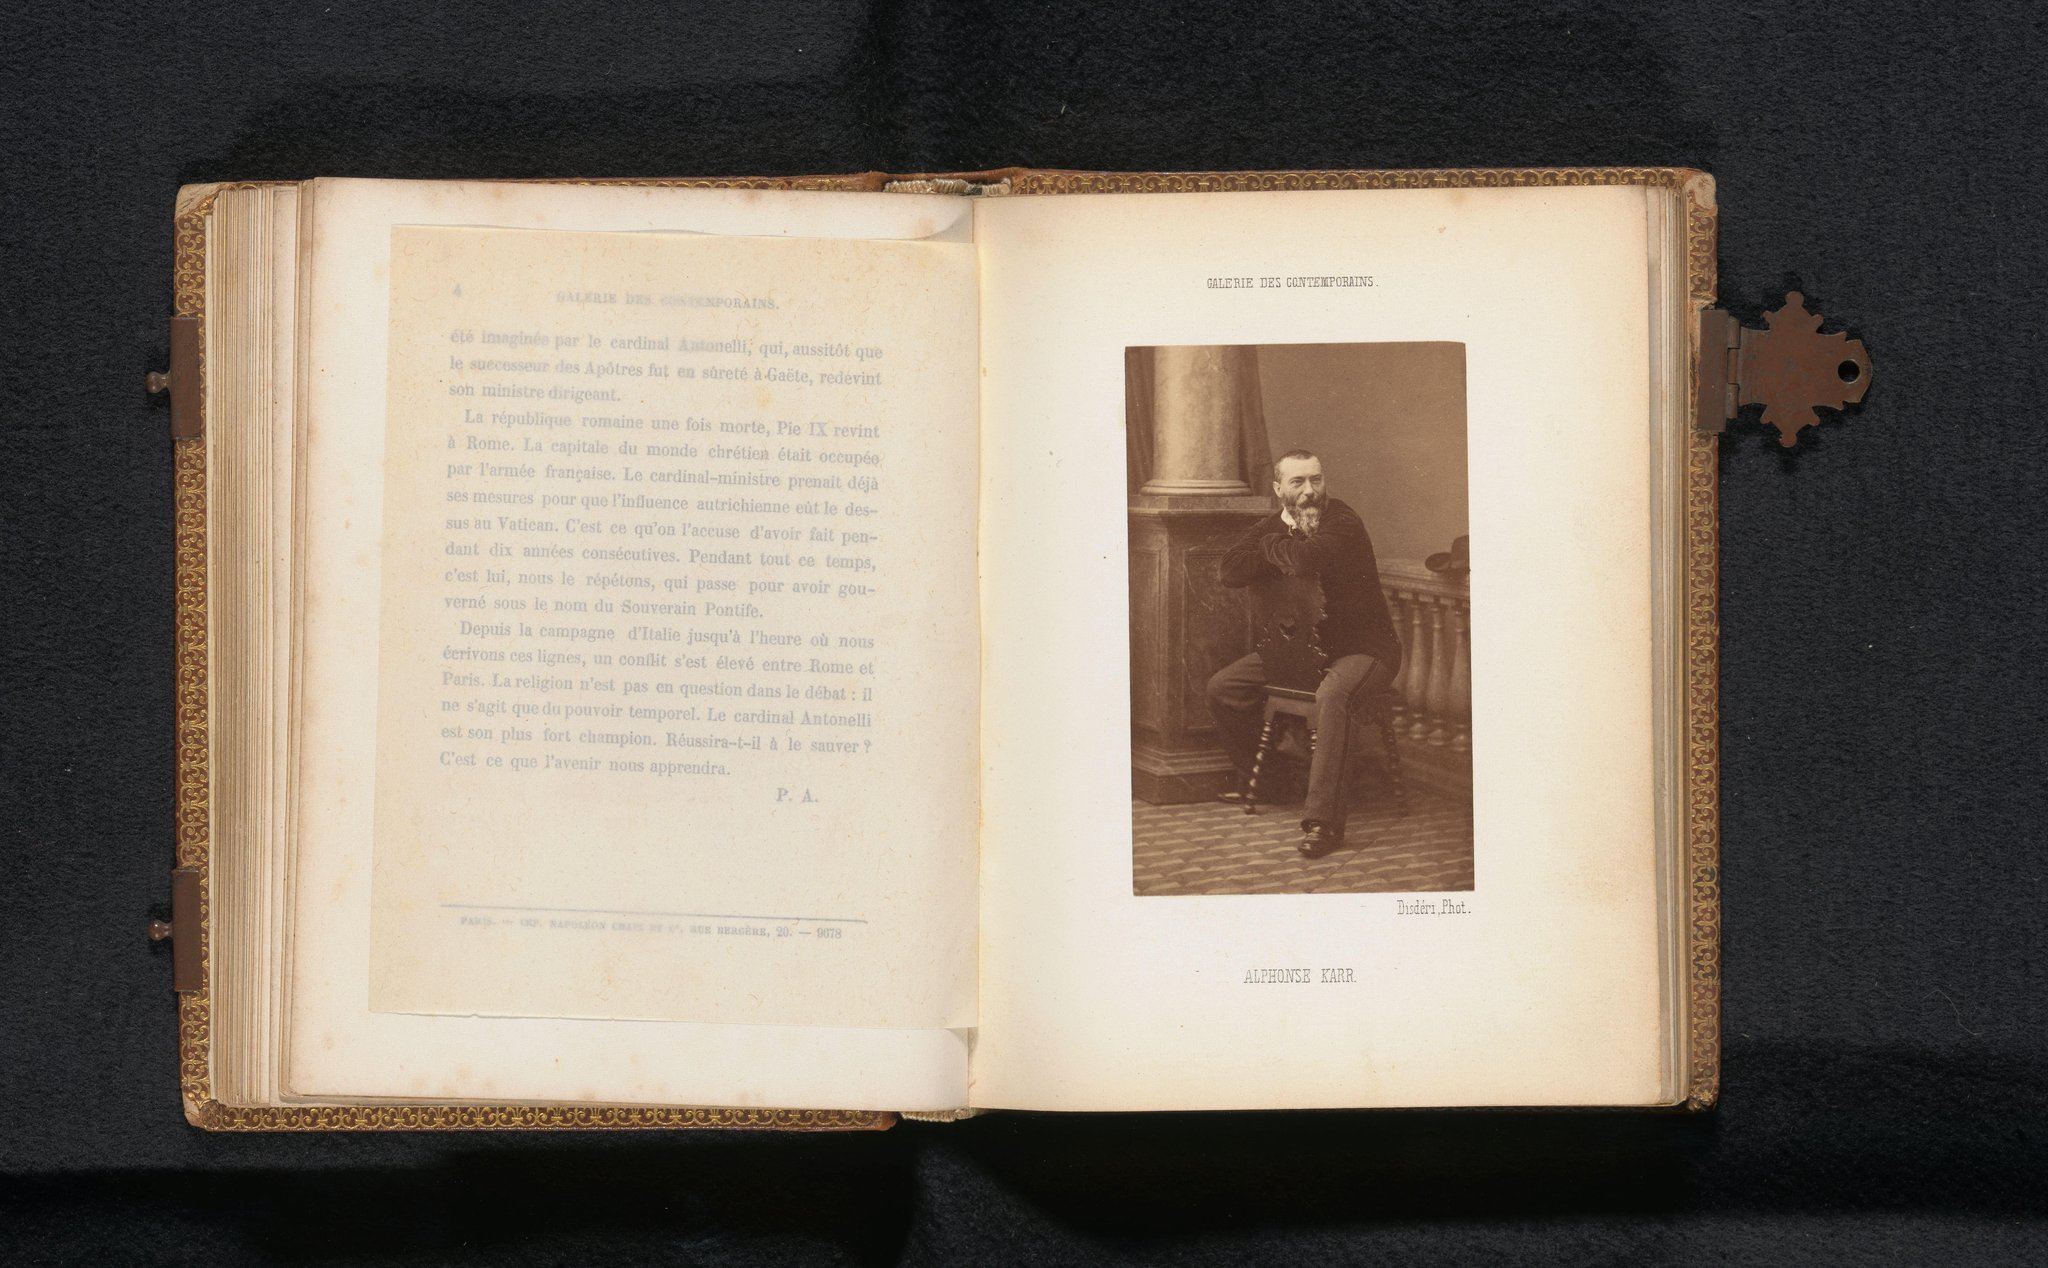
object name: page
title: Portret van Jean-Baptiste Alphonse Kar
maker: andré-adolphe-eugène disdéri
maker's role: fotograaf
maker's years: 1819-1889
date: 1857-1862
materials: photographic support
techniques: albumen print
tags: paris, alphonse karr, adult man, historical persons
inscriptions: inscription: ‘Galerie des Contemporains’